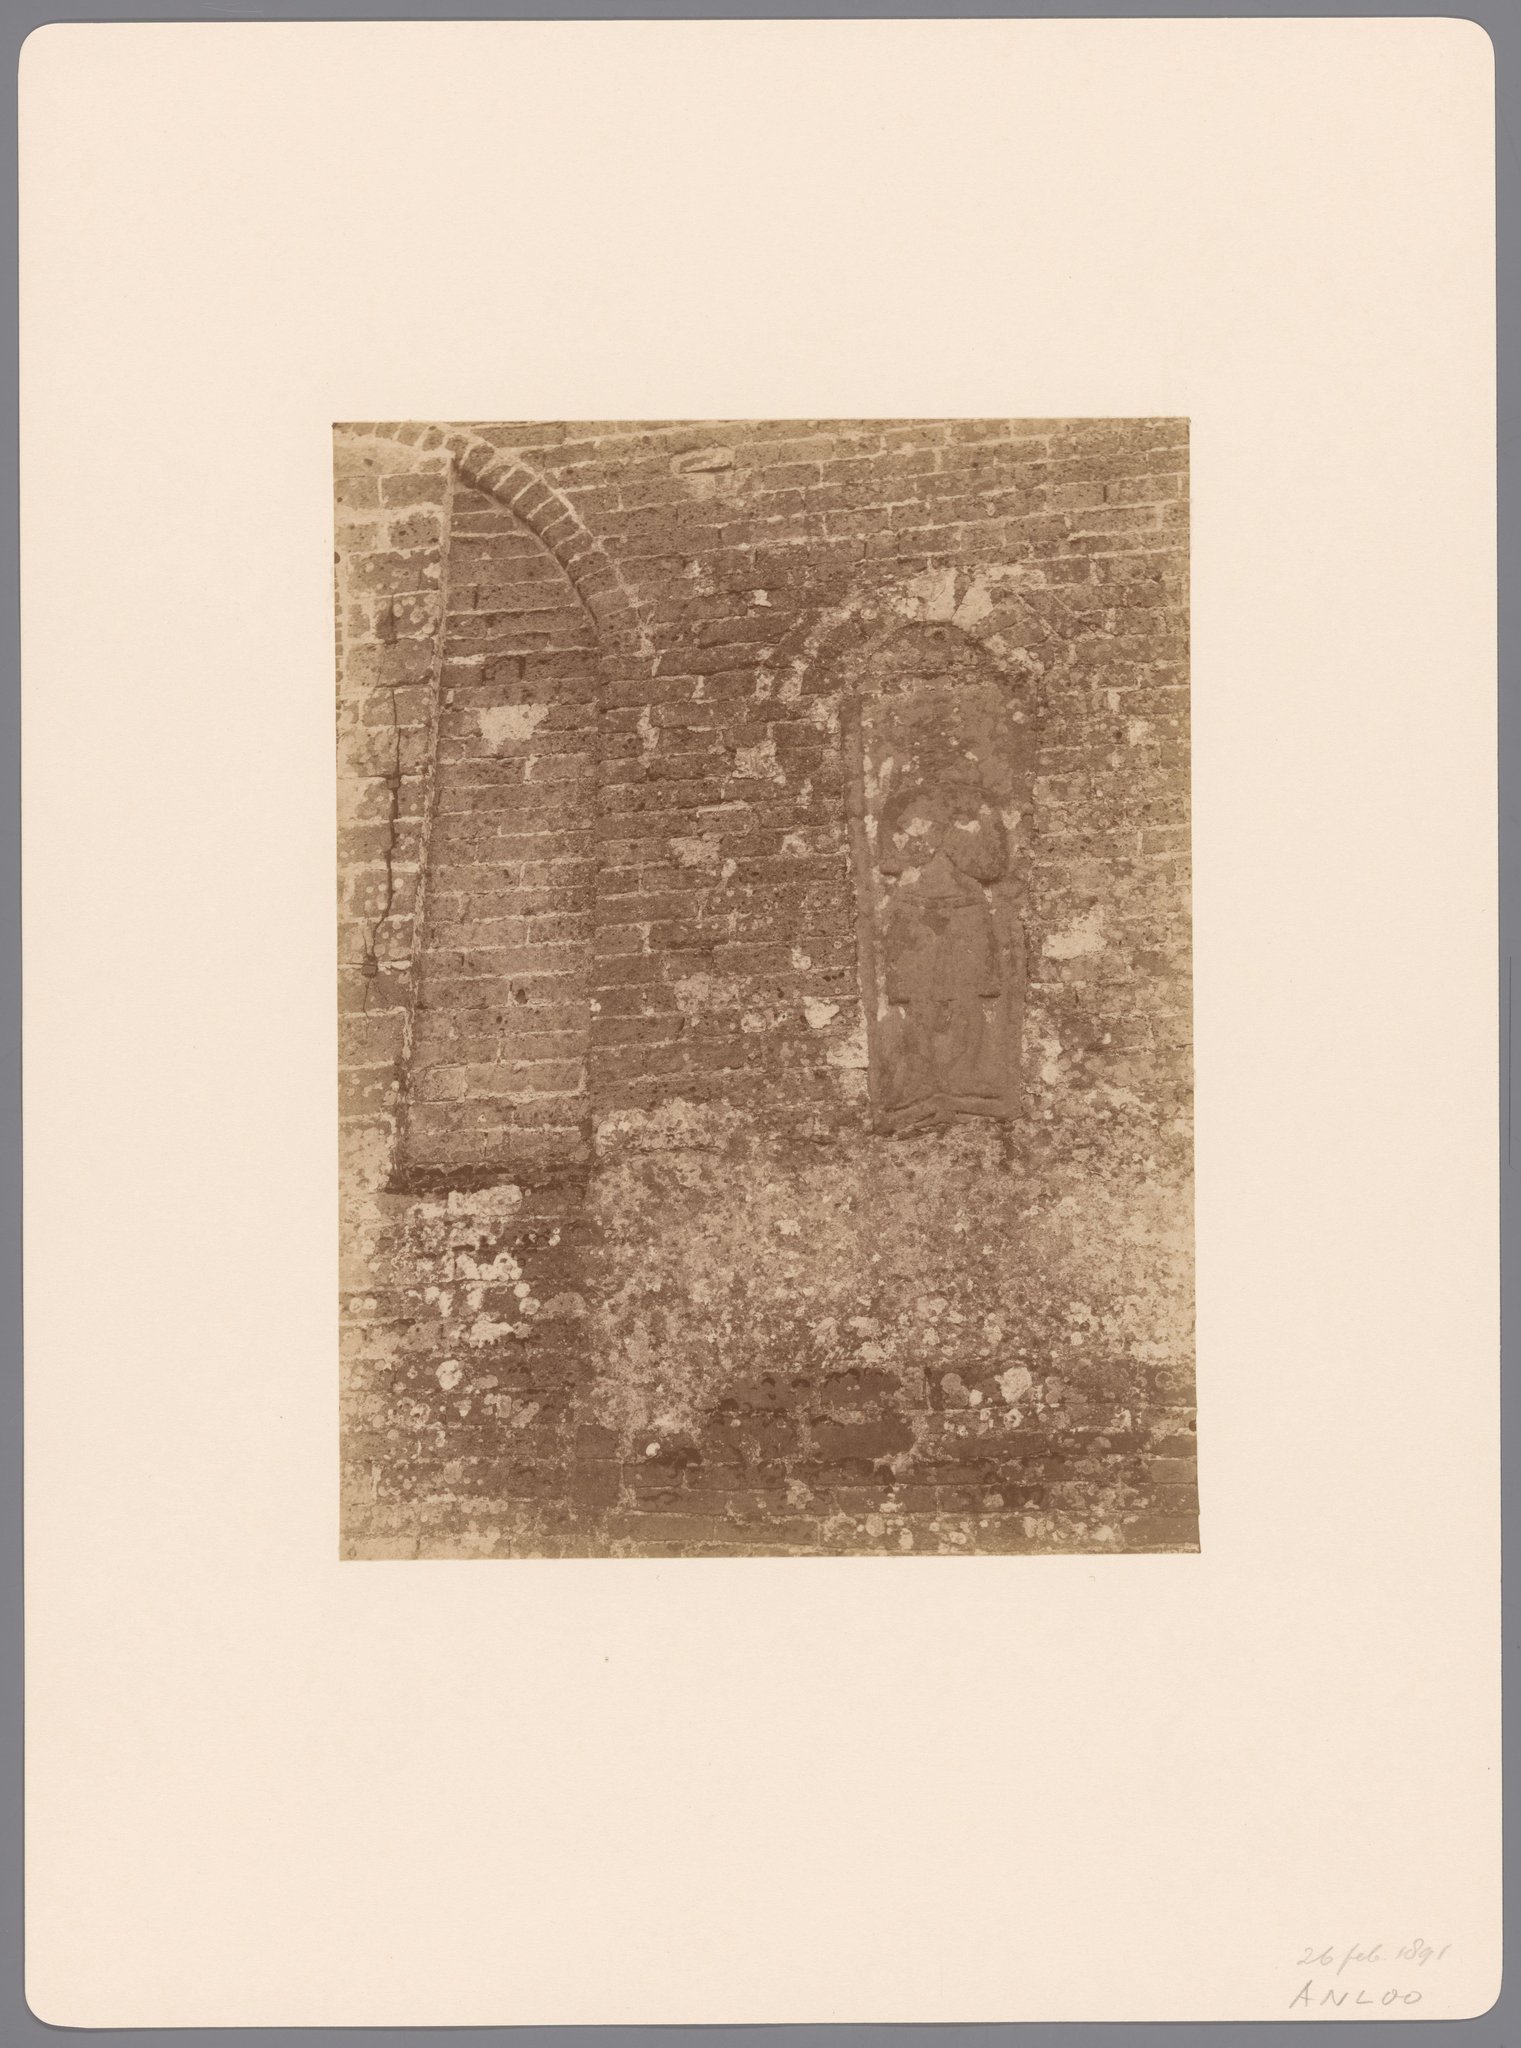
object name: photograph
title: Detail van de Magnuskerk te Anloo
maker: anoniem (monumentenzorg)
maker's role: fotograaf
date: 1891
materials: cardboard, photographic support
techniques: albumen print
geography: anloo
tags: church (exterior), sculpture (+ relief ~ sculpture)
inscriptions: annotation: ‘8’, annotation: ‘26 feb. 1891/ Anloo’